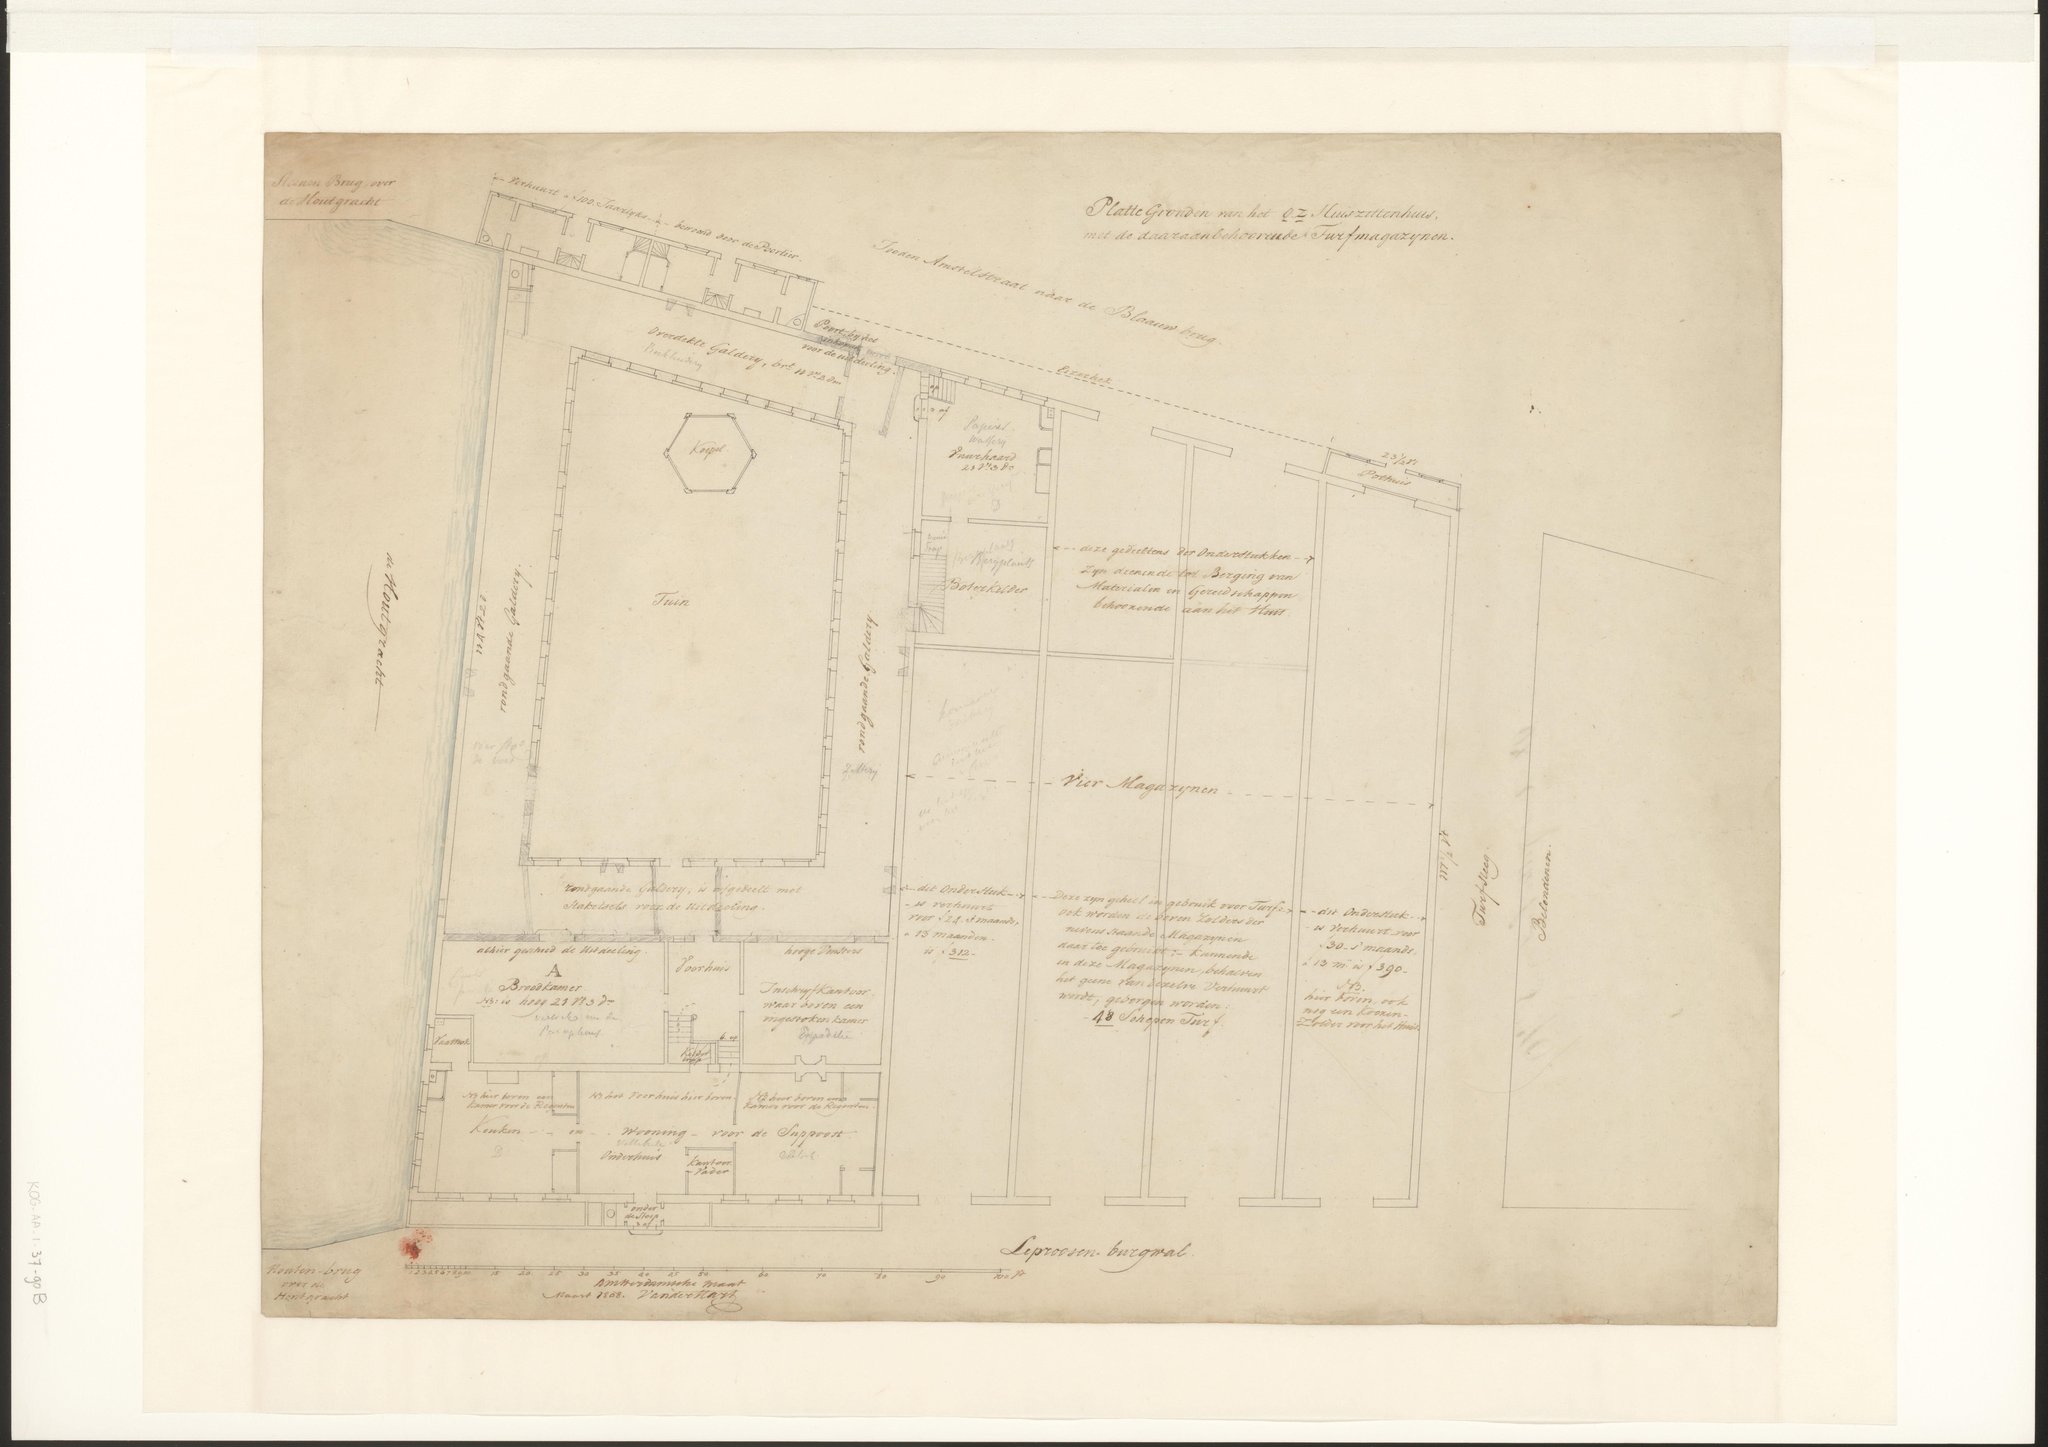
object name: print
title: Het Oude-Zyds-Huiszitten-Aalmoesseniers-Huis, van agteren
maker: Anonymous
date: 1765-1782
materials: paper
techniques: engraving, etching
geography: northern netherlands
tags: poorhouse, courtyard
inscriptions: collector's mark: Lugt 1641b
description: Afdruk van de volledige plaat ook gebruikt in: Wagenaar, Jan. Amsterdam, in zyne opkomst, aanwas, geschiedenissen (…). Amsterdam: Isaak Tirion, 1765, dl. 2. En in: Verzameling der fraaiste gezigten van Amsterdam in negen en zeventig afbeeldingen. Amsterdam en Harlingen: Petrus Conradi en Volkert van der Plaats, 1782.